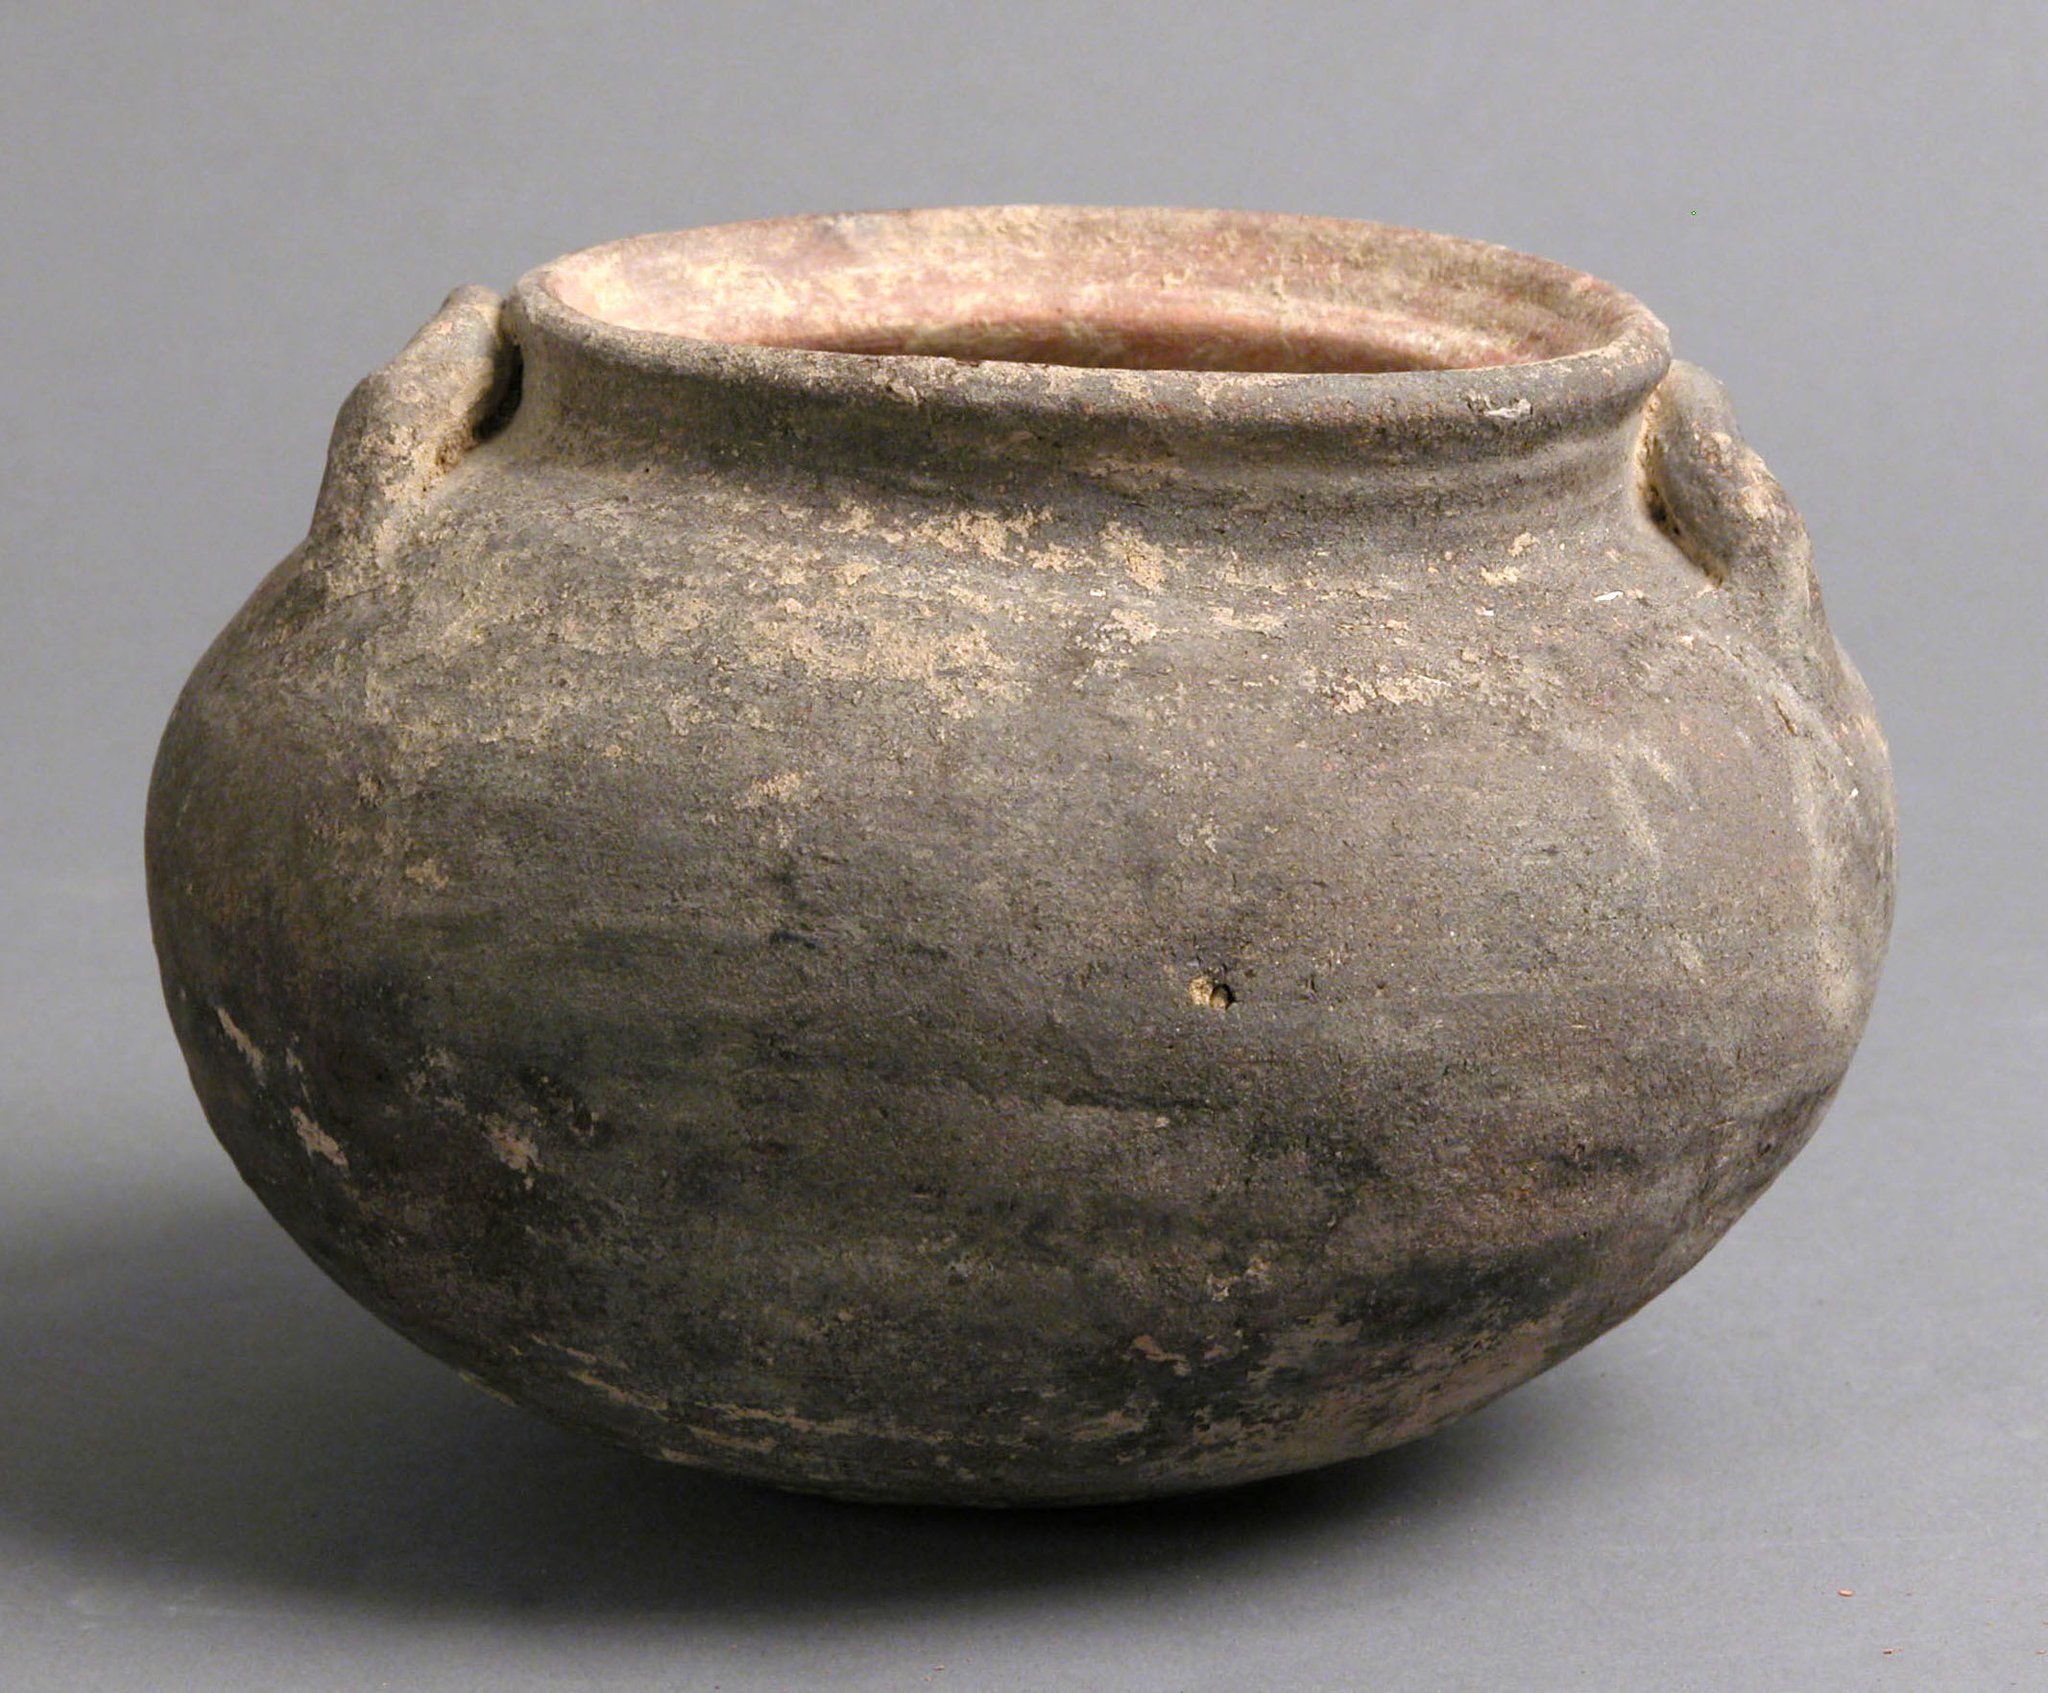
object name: pot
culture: coptic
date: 401-900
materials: earthenware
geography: egypt